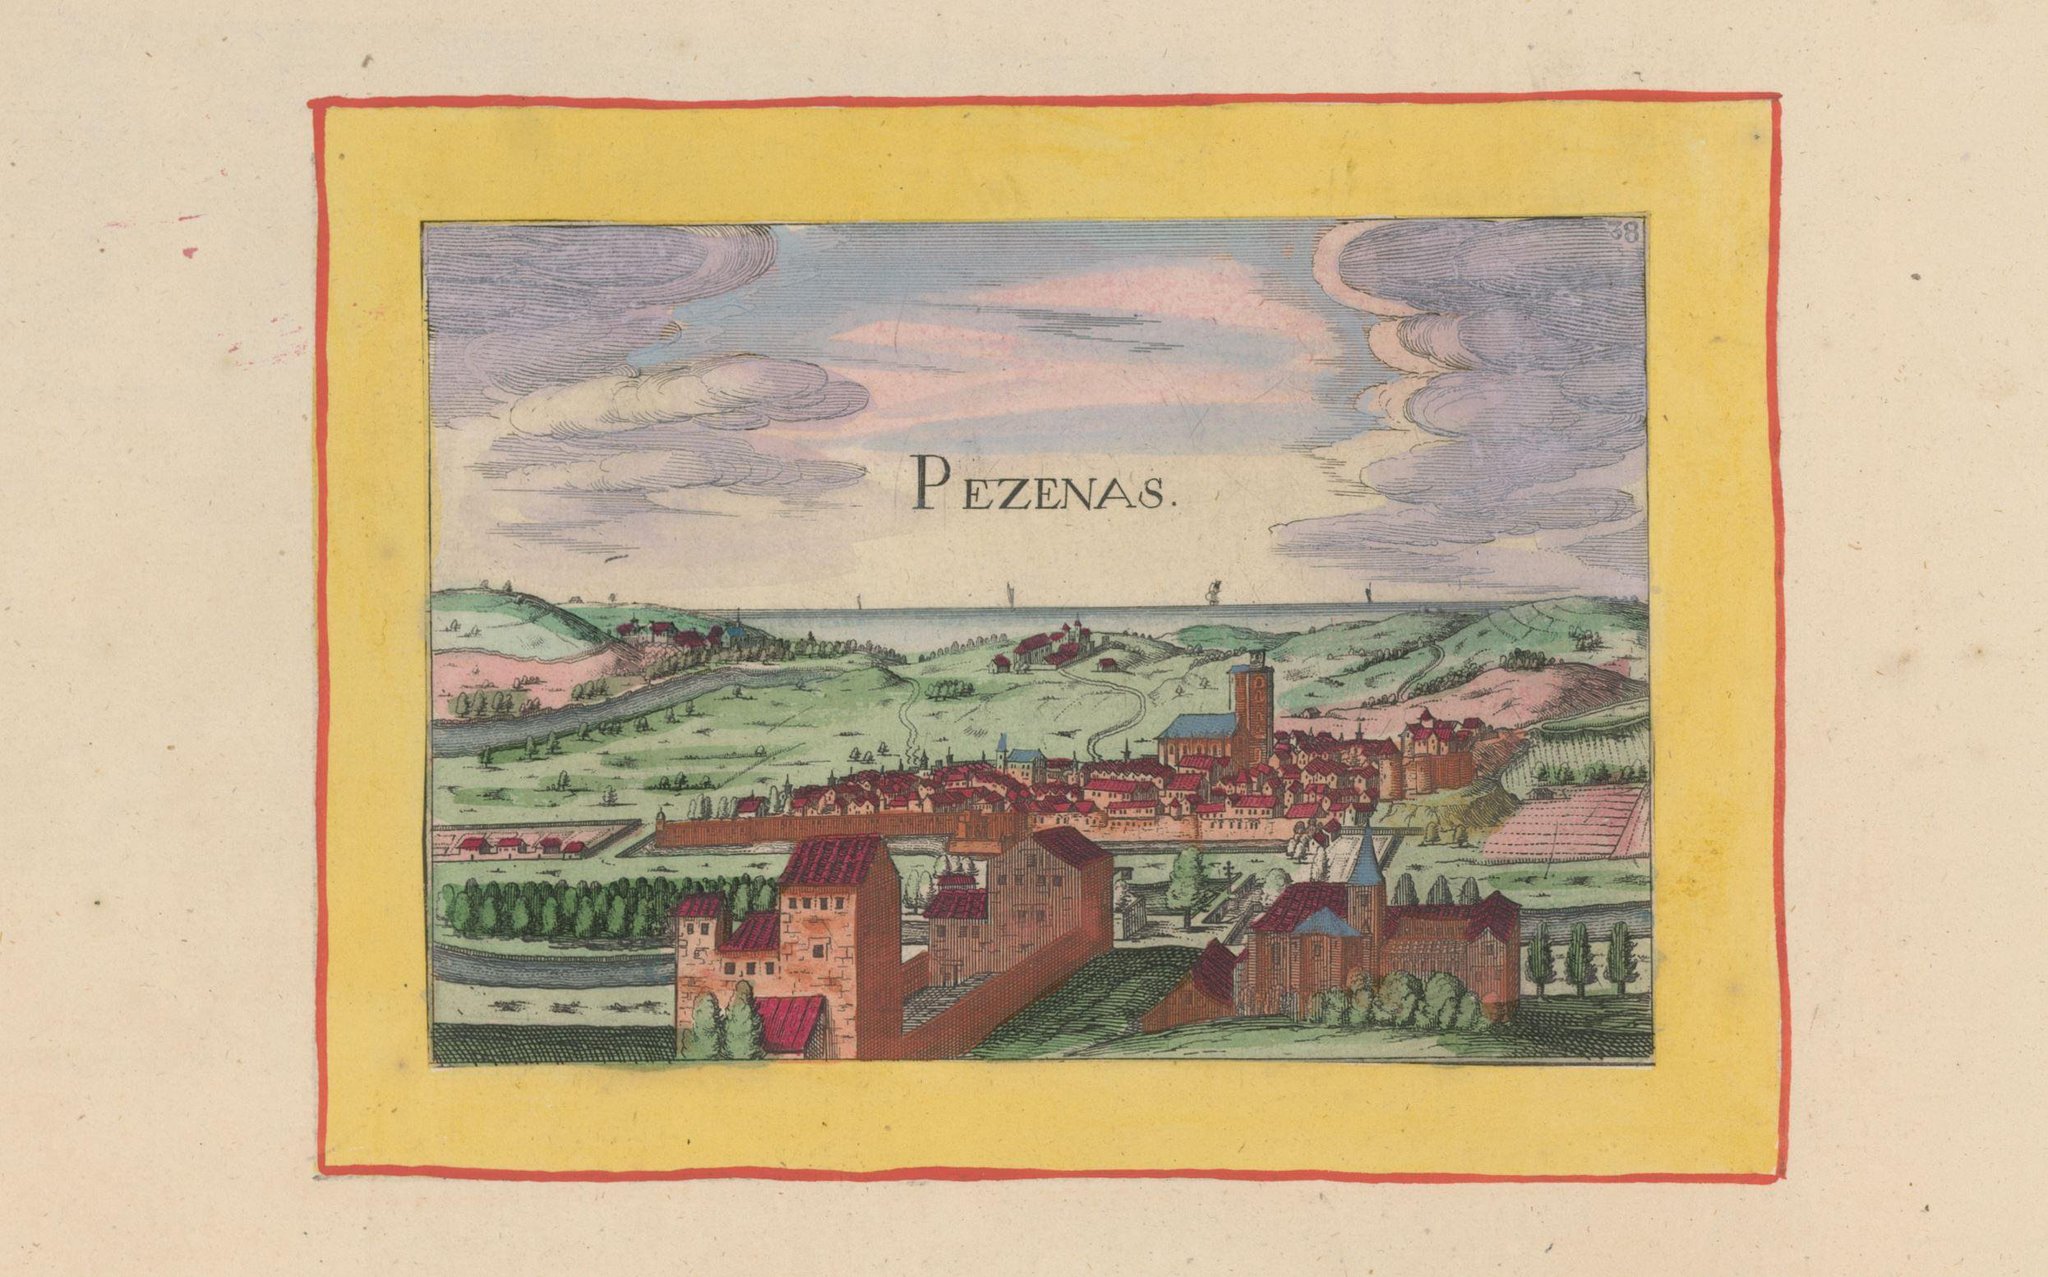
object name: print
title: Gezicht op Pézenas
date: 1638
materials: paper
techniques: engraving, etching, hand coloring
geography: the hague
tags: city-view in general; 'veduta'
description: Prent uit: Tassin, Christophe. Les plans et profils de toutes les principales villes et lieux considérables de France (...). Parijs: Michel van Lochom, 1638, prent nummer 38 in het deel 'Languedoc'.